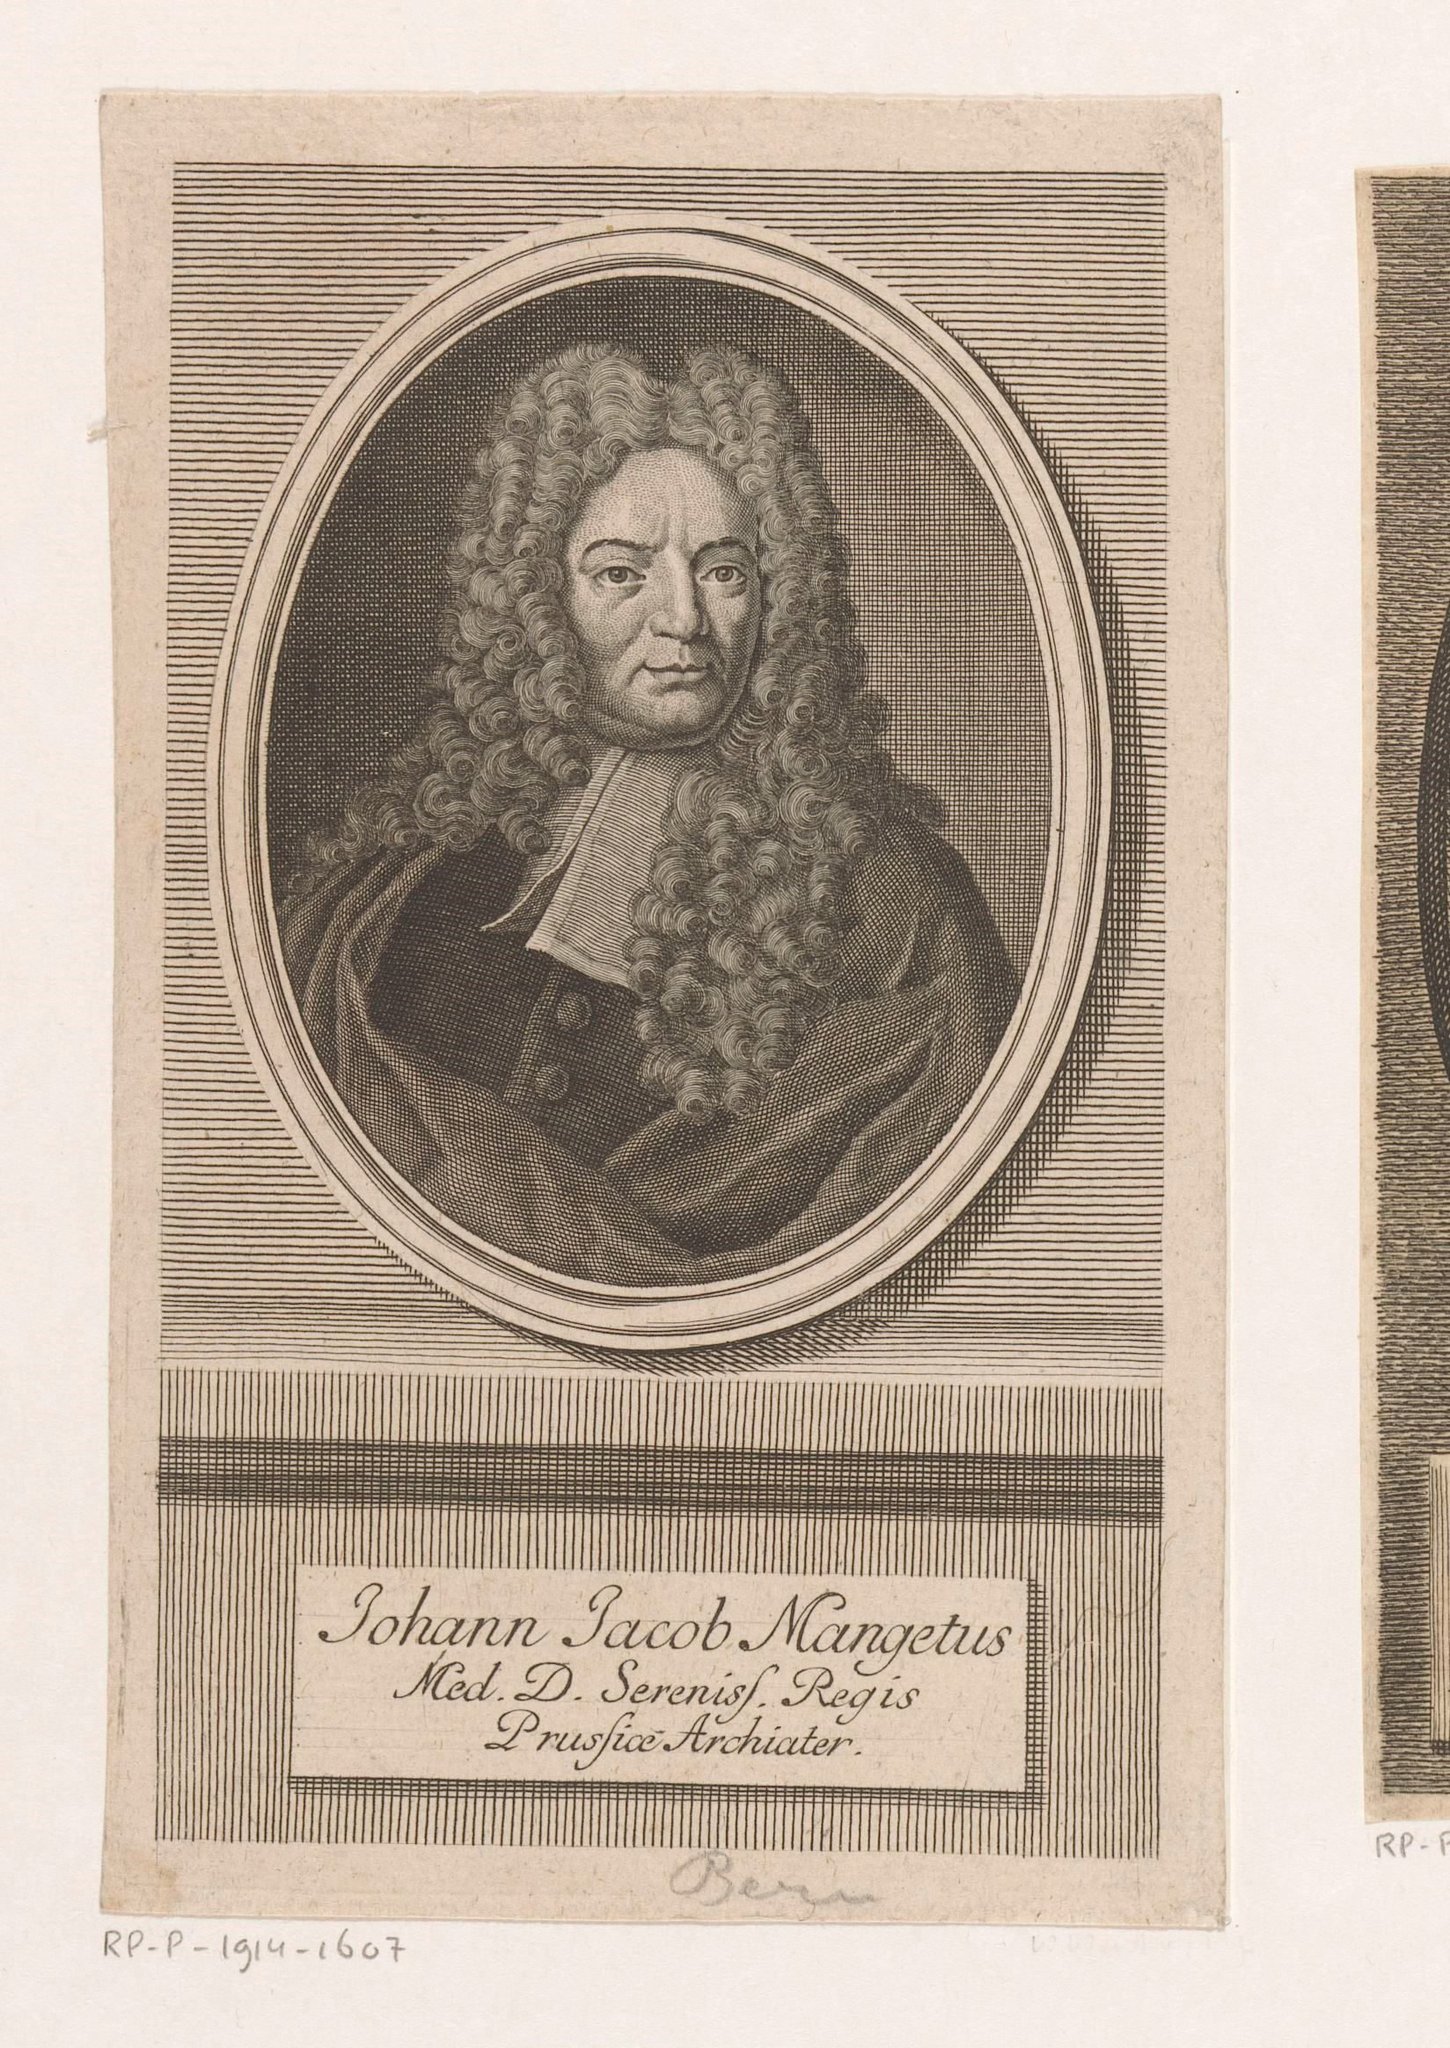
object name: print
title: Portret van Jean-Jacques Manget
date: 1699-1742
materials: paper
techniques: engraving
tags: historical persons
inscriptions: collector's mark: Lugt 2228